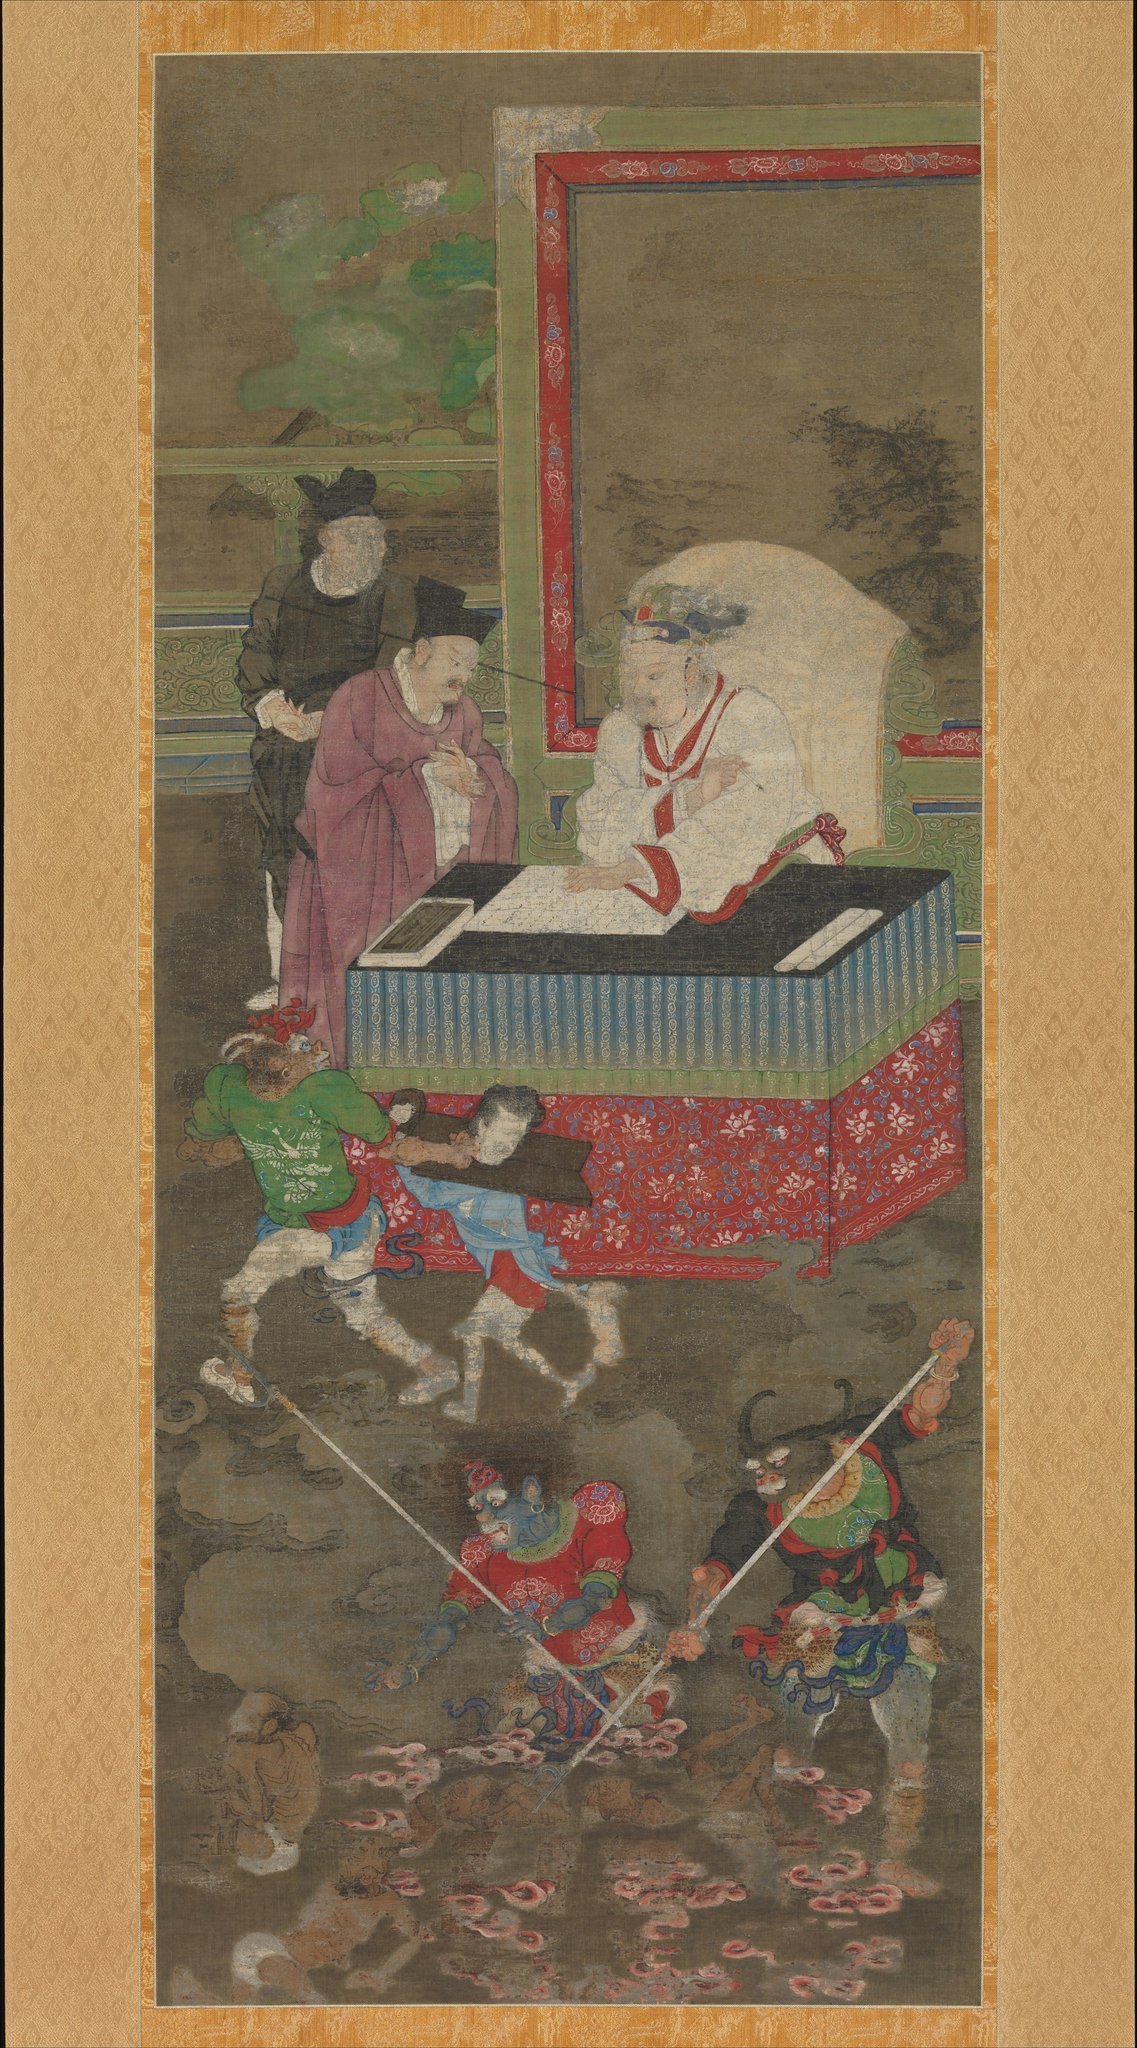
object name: hanging scroll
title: Ten Kings of Hell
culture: chinese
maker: jin chushi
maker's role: artist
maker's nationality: chinese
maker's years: 1167-1199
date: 1195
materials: ink, silk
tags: kings,men,buddhism,demons,hell